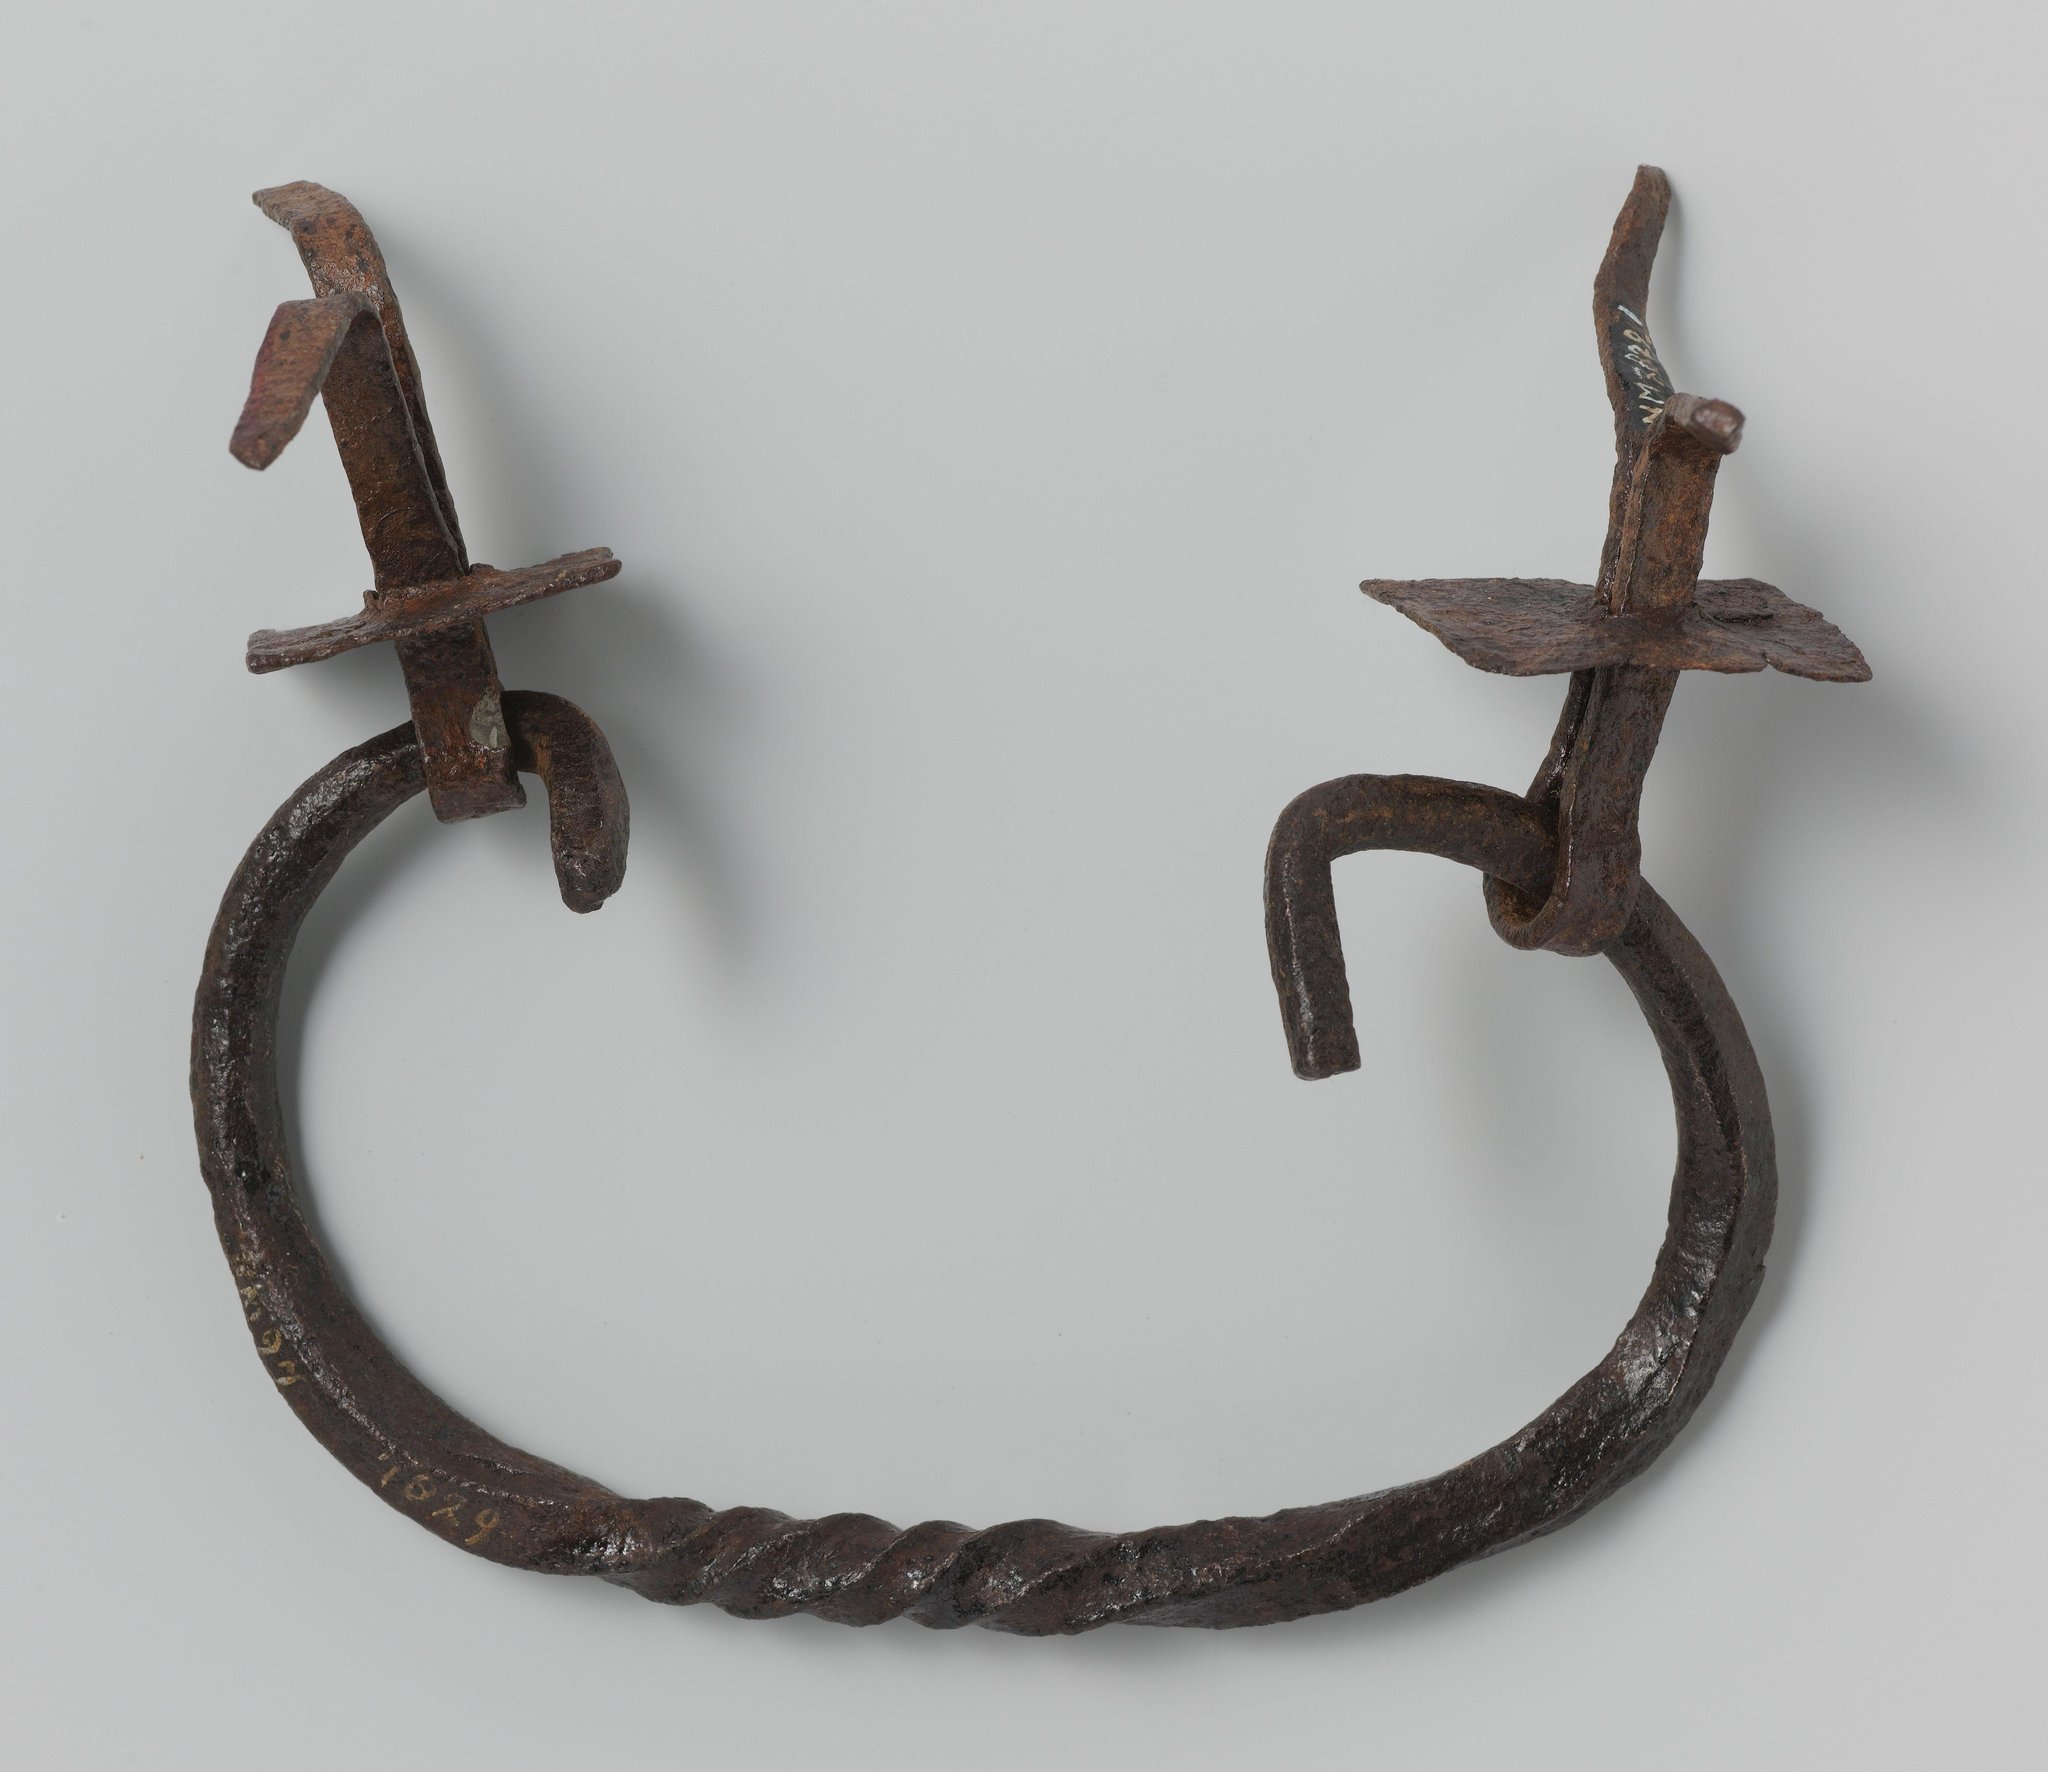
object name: fragment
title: Lis behorende bij een handgreep van een kist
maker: Anonymous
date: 1590-1596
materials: iron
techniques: forging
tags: willem barendsz., amsterdam, jacob van heemskerck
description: Lis behorende bij een handgreep van een kist.